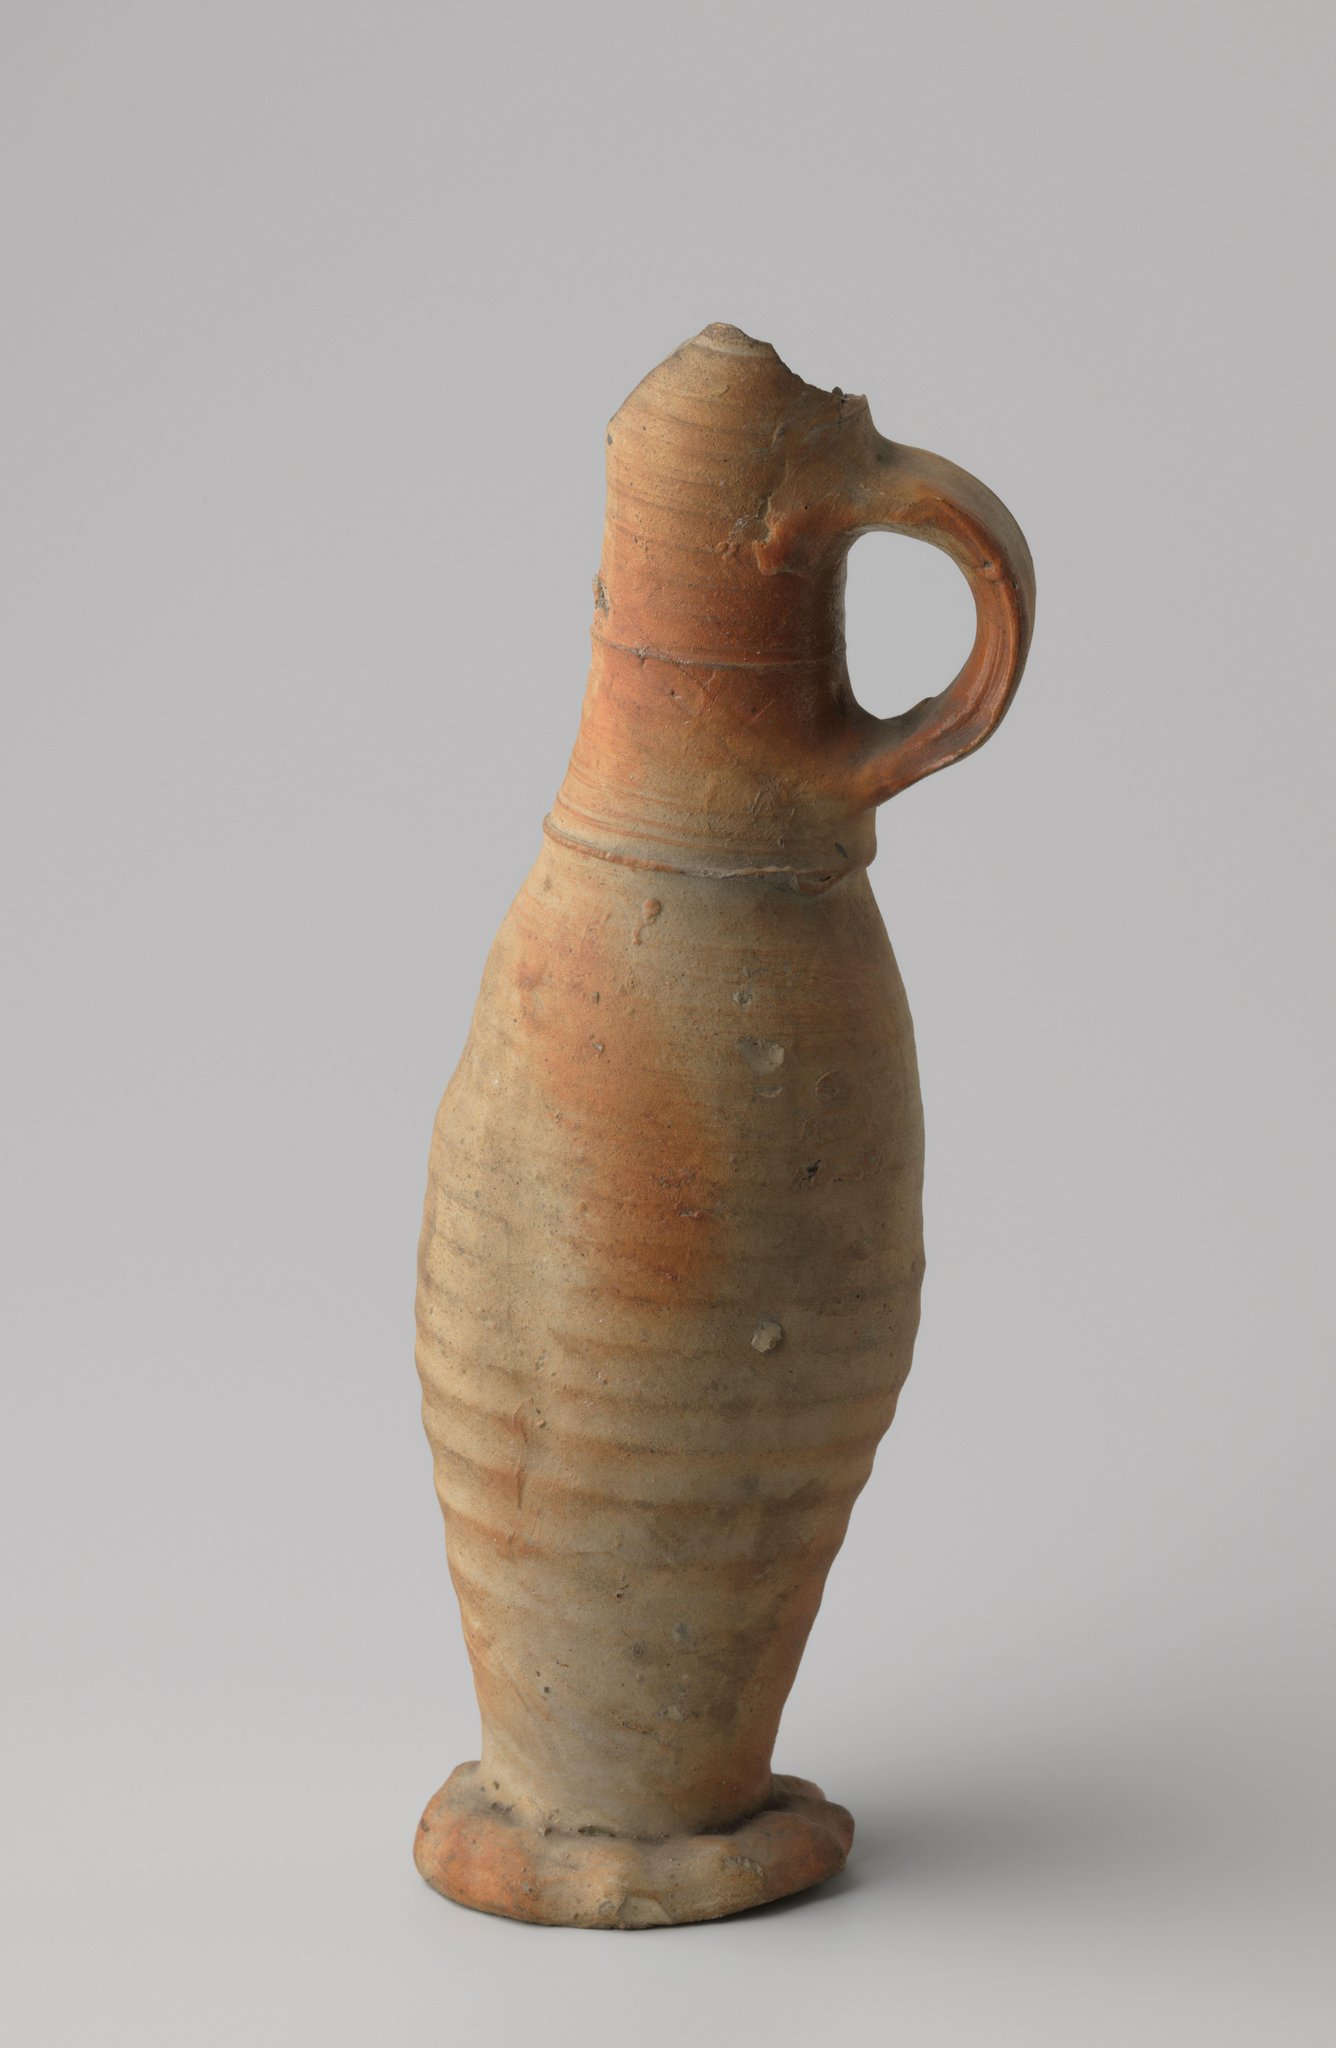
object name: ewer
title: Fragment of a jug or 'Jacobakan'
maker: Anonymous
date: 1450-1599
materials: stoneware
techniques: firing, forming, turning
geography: germany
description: Fragment van een geribde, smalle kan (Jacobakan) van steengoed op gegolfde voet met een eivormig lichaam en lange nek. Rand ontbreekt. De buik is ingeknepen. Het C-vormige oor is bevestigd aan de nek. De kan is versierd met draairingen en een profiel op de schouder. Het bovenste deel van de buik is gladgestreken.